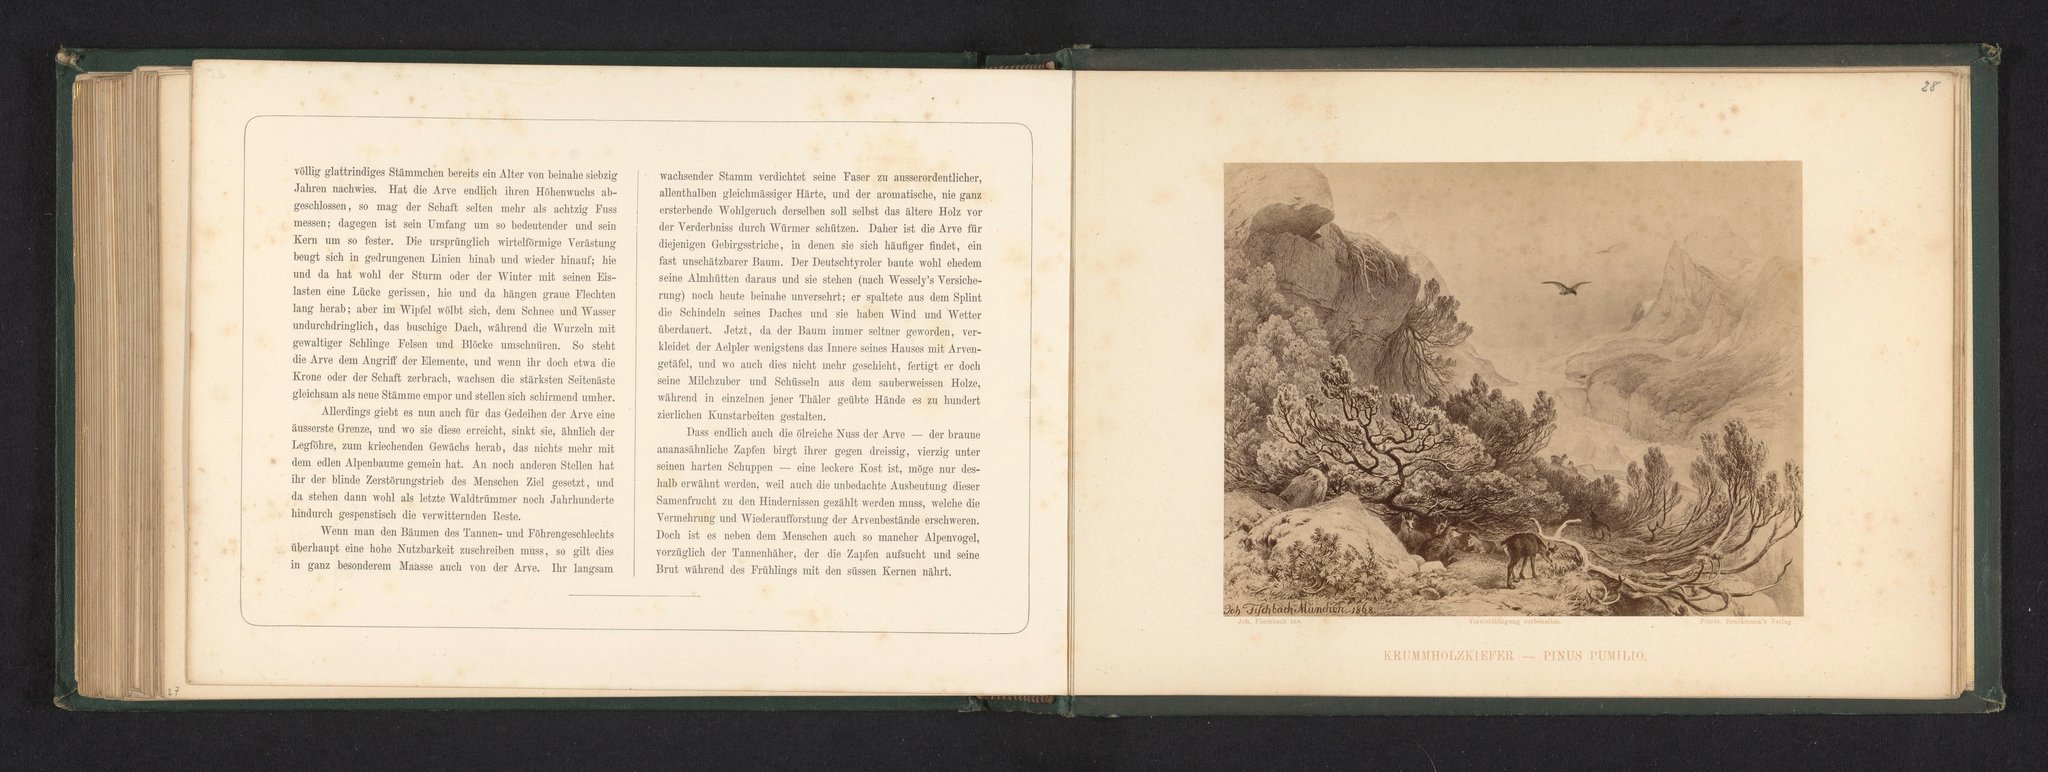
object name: page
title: Krummholzkiefer - Pinus Pumilio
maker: johann fischbach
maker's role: painter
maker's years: 1797-1871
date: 1868-1878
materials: photographic support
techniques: albumen print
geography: munich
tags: predatory birds, goat, trees: pine